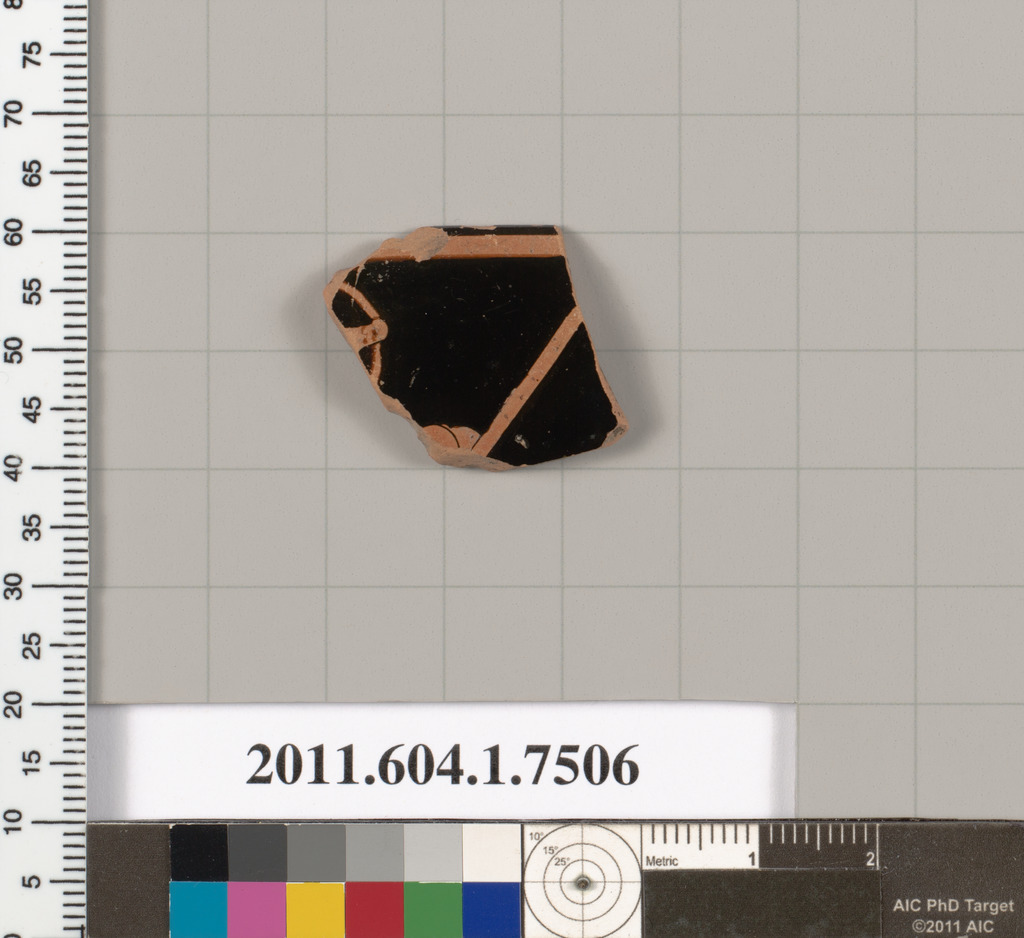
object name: kylix fragment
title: Terracotta rim fragment of a kylix (drinking cup)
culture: greek, attic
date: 460-450 BCE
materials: terracotta